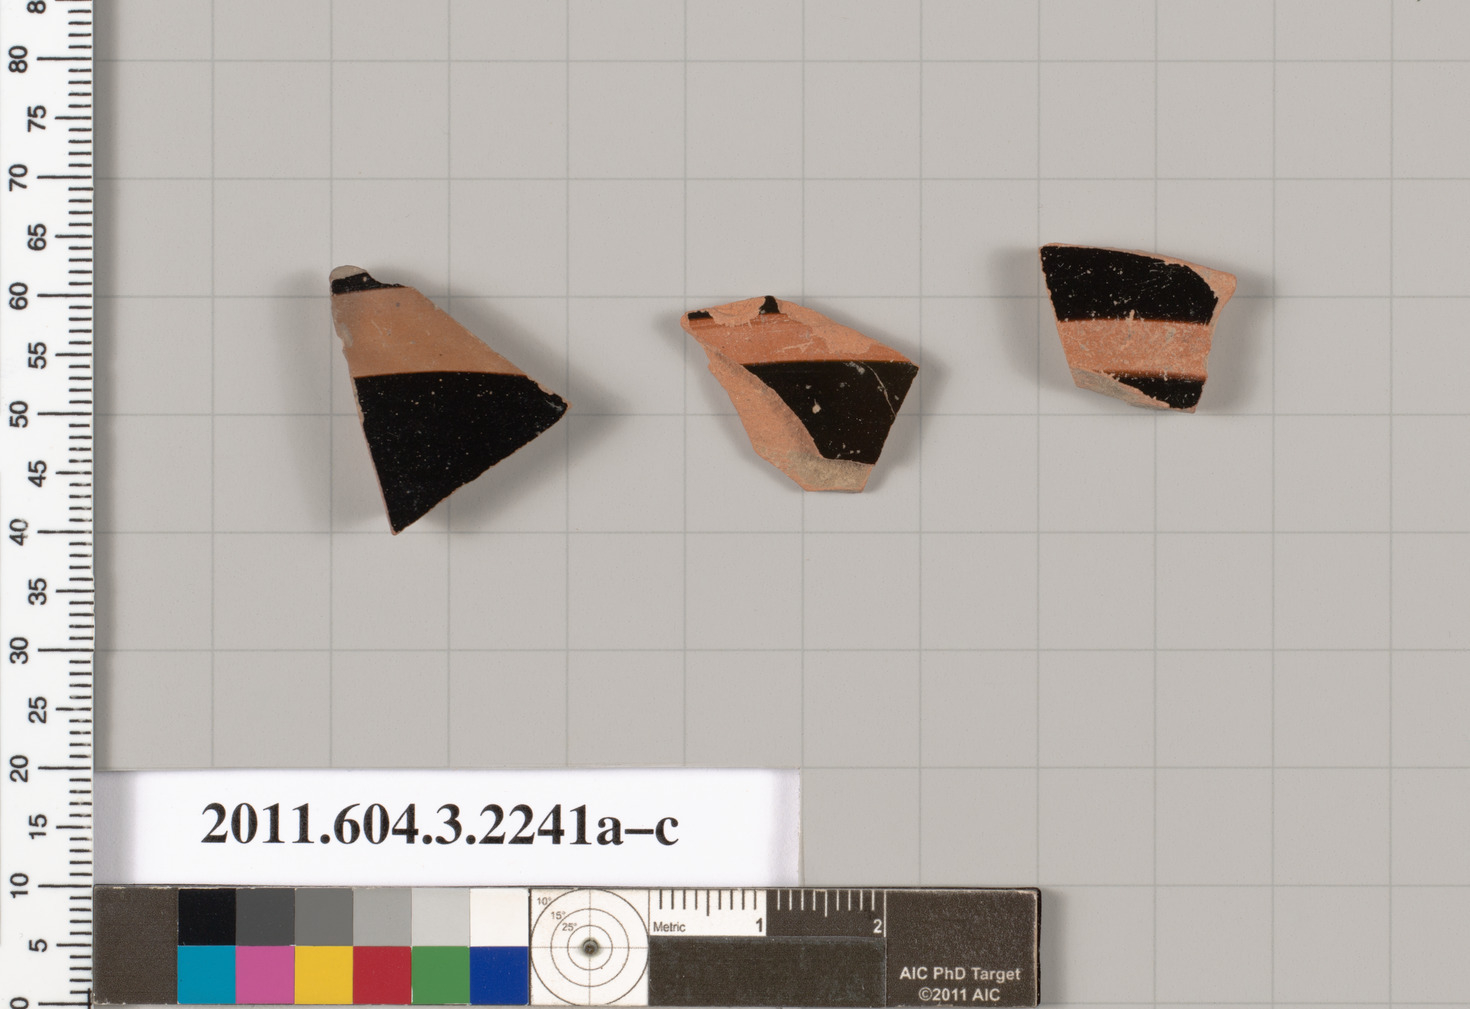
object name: kylix fragment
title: Terracotta fragments of kylikes (drinking cups)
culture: greek, attic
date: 600-401 BCE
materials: terracotta